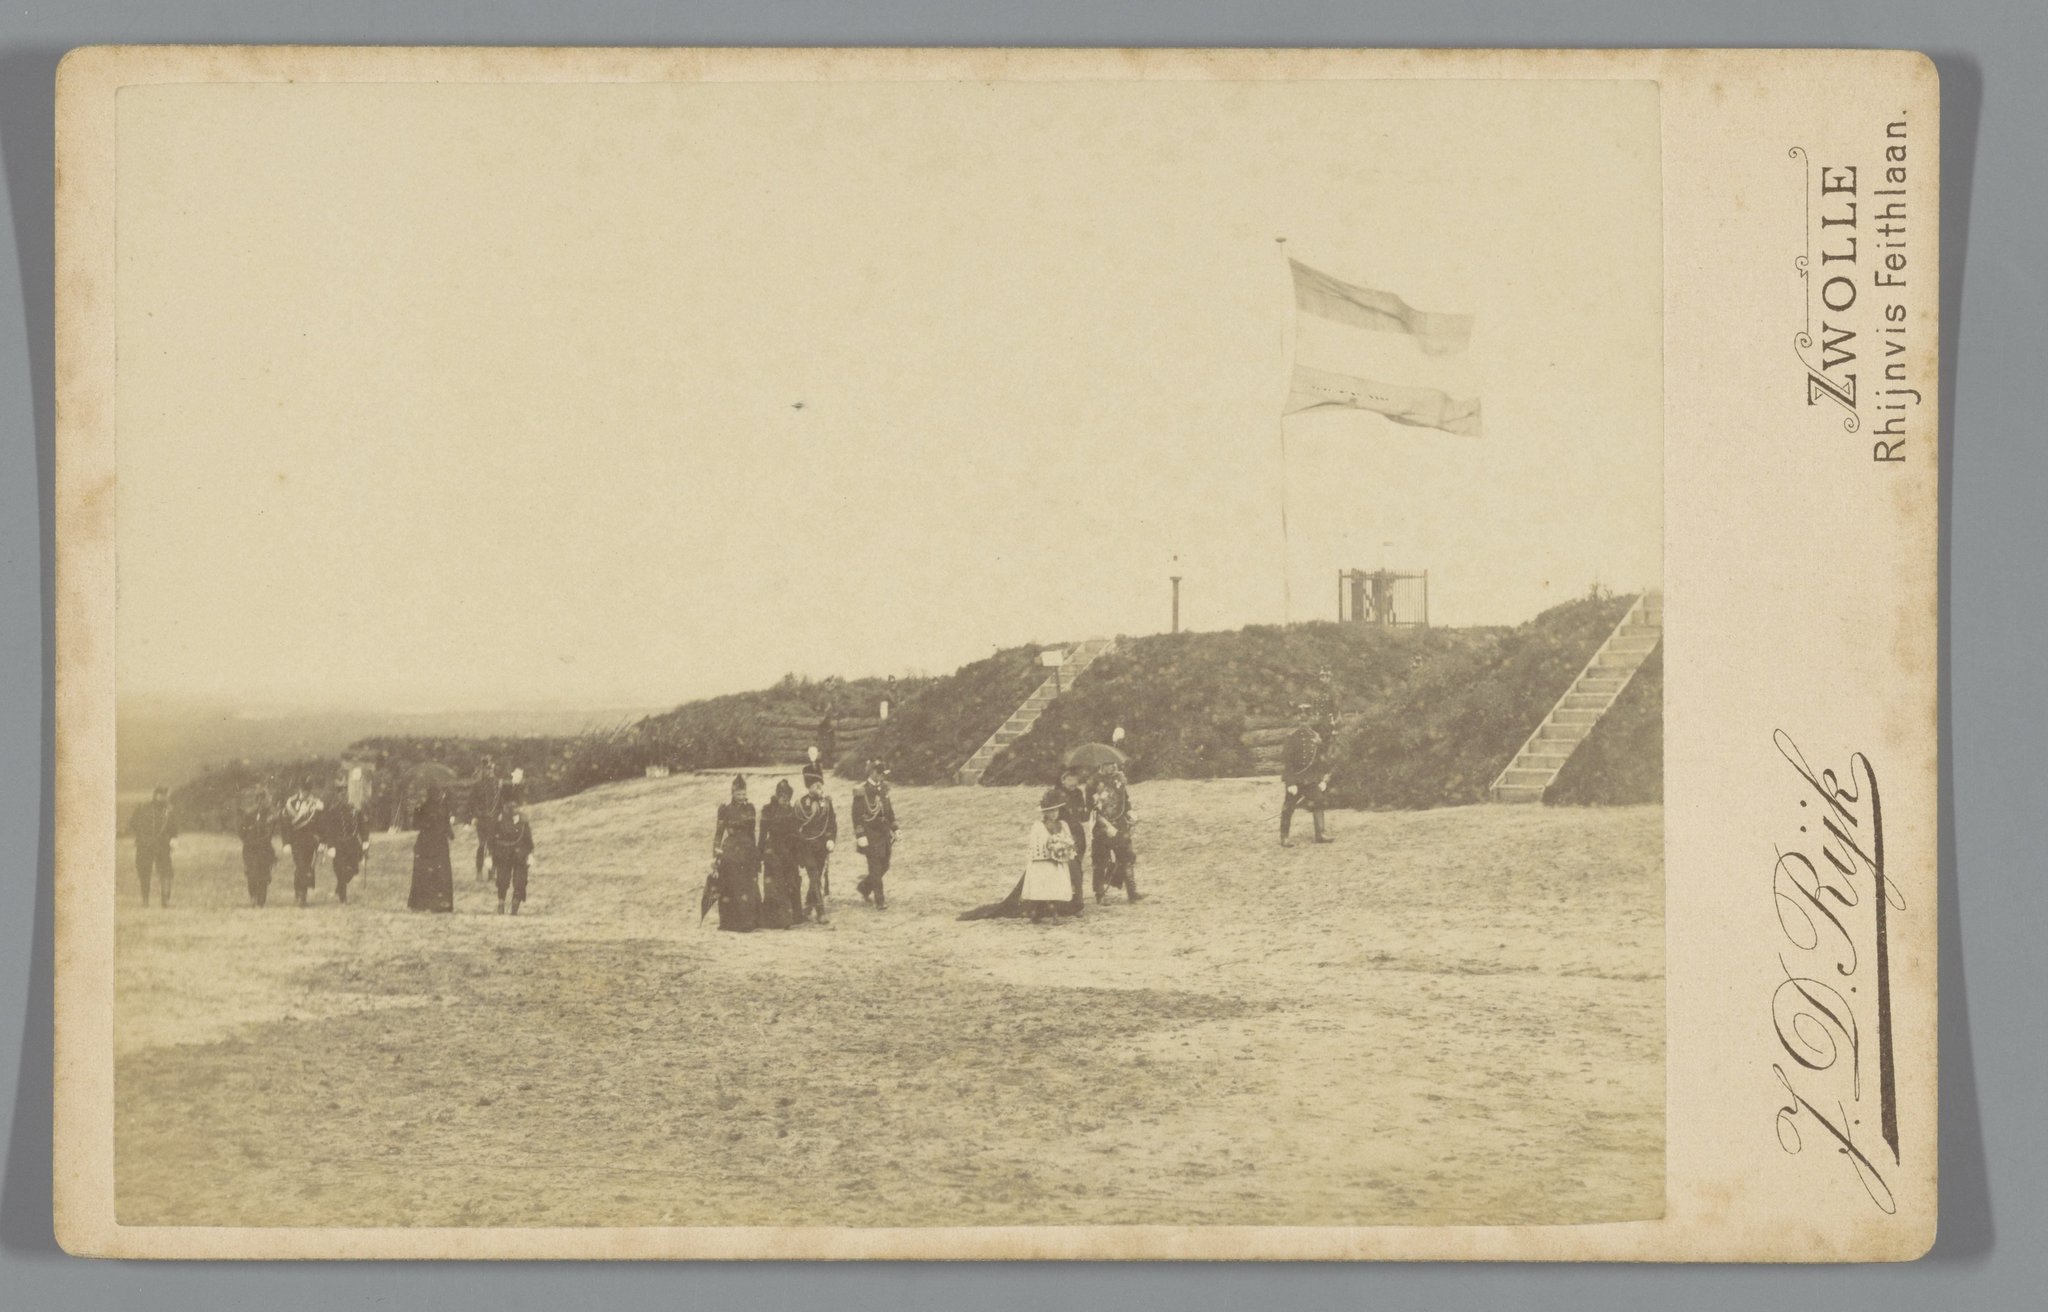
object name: cabinet photograph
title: Bezoek van koningin Emma en prinses Wilhelmina aan de legerplaats bij Oldebroek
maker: jacques daniël rijk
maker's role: draughtsman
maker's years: 1855-1912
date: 1891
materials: cardboard, paper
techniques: albumen print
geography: oldebroek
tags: the hague, wilhelmina of the netherlands, emma (queen consort of the netherlands), historical persons - bb - woman, queen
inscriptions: collector's mark: ‘Vosmaer’